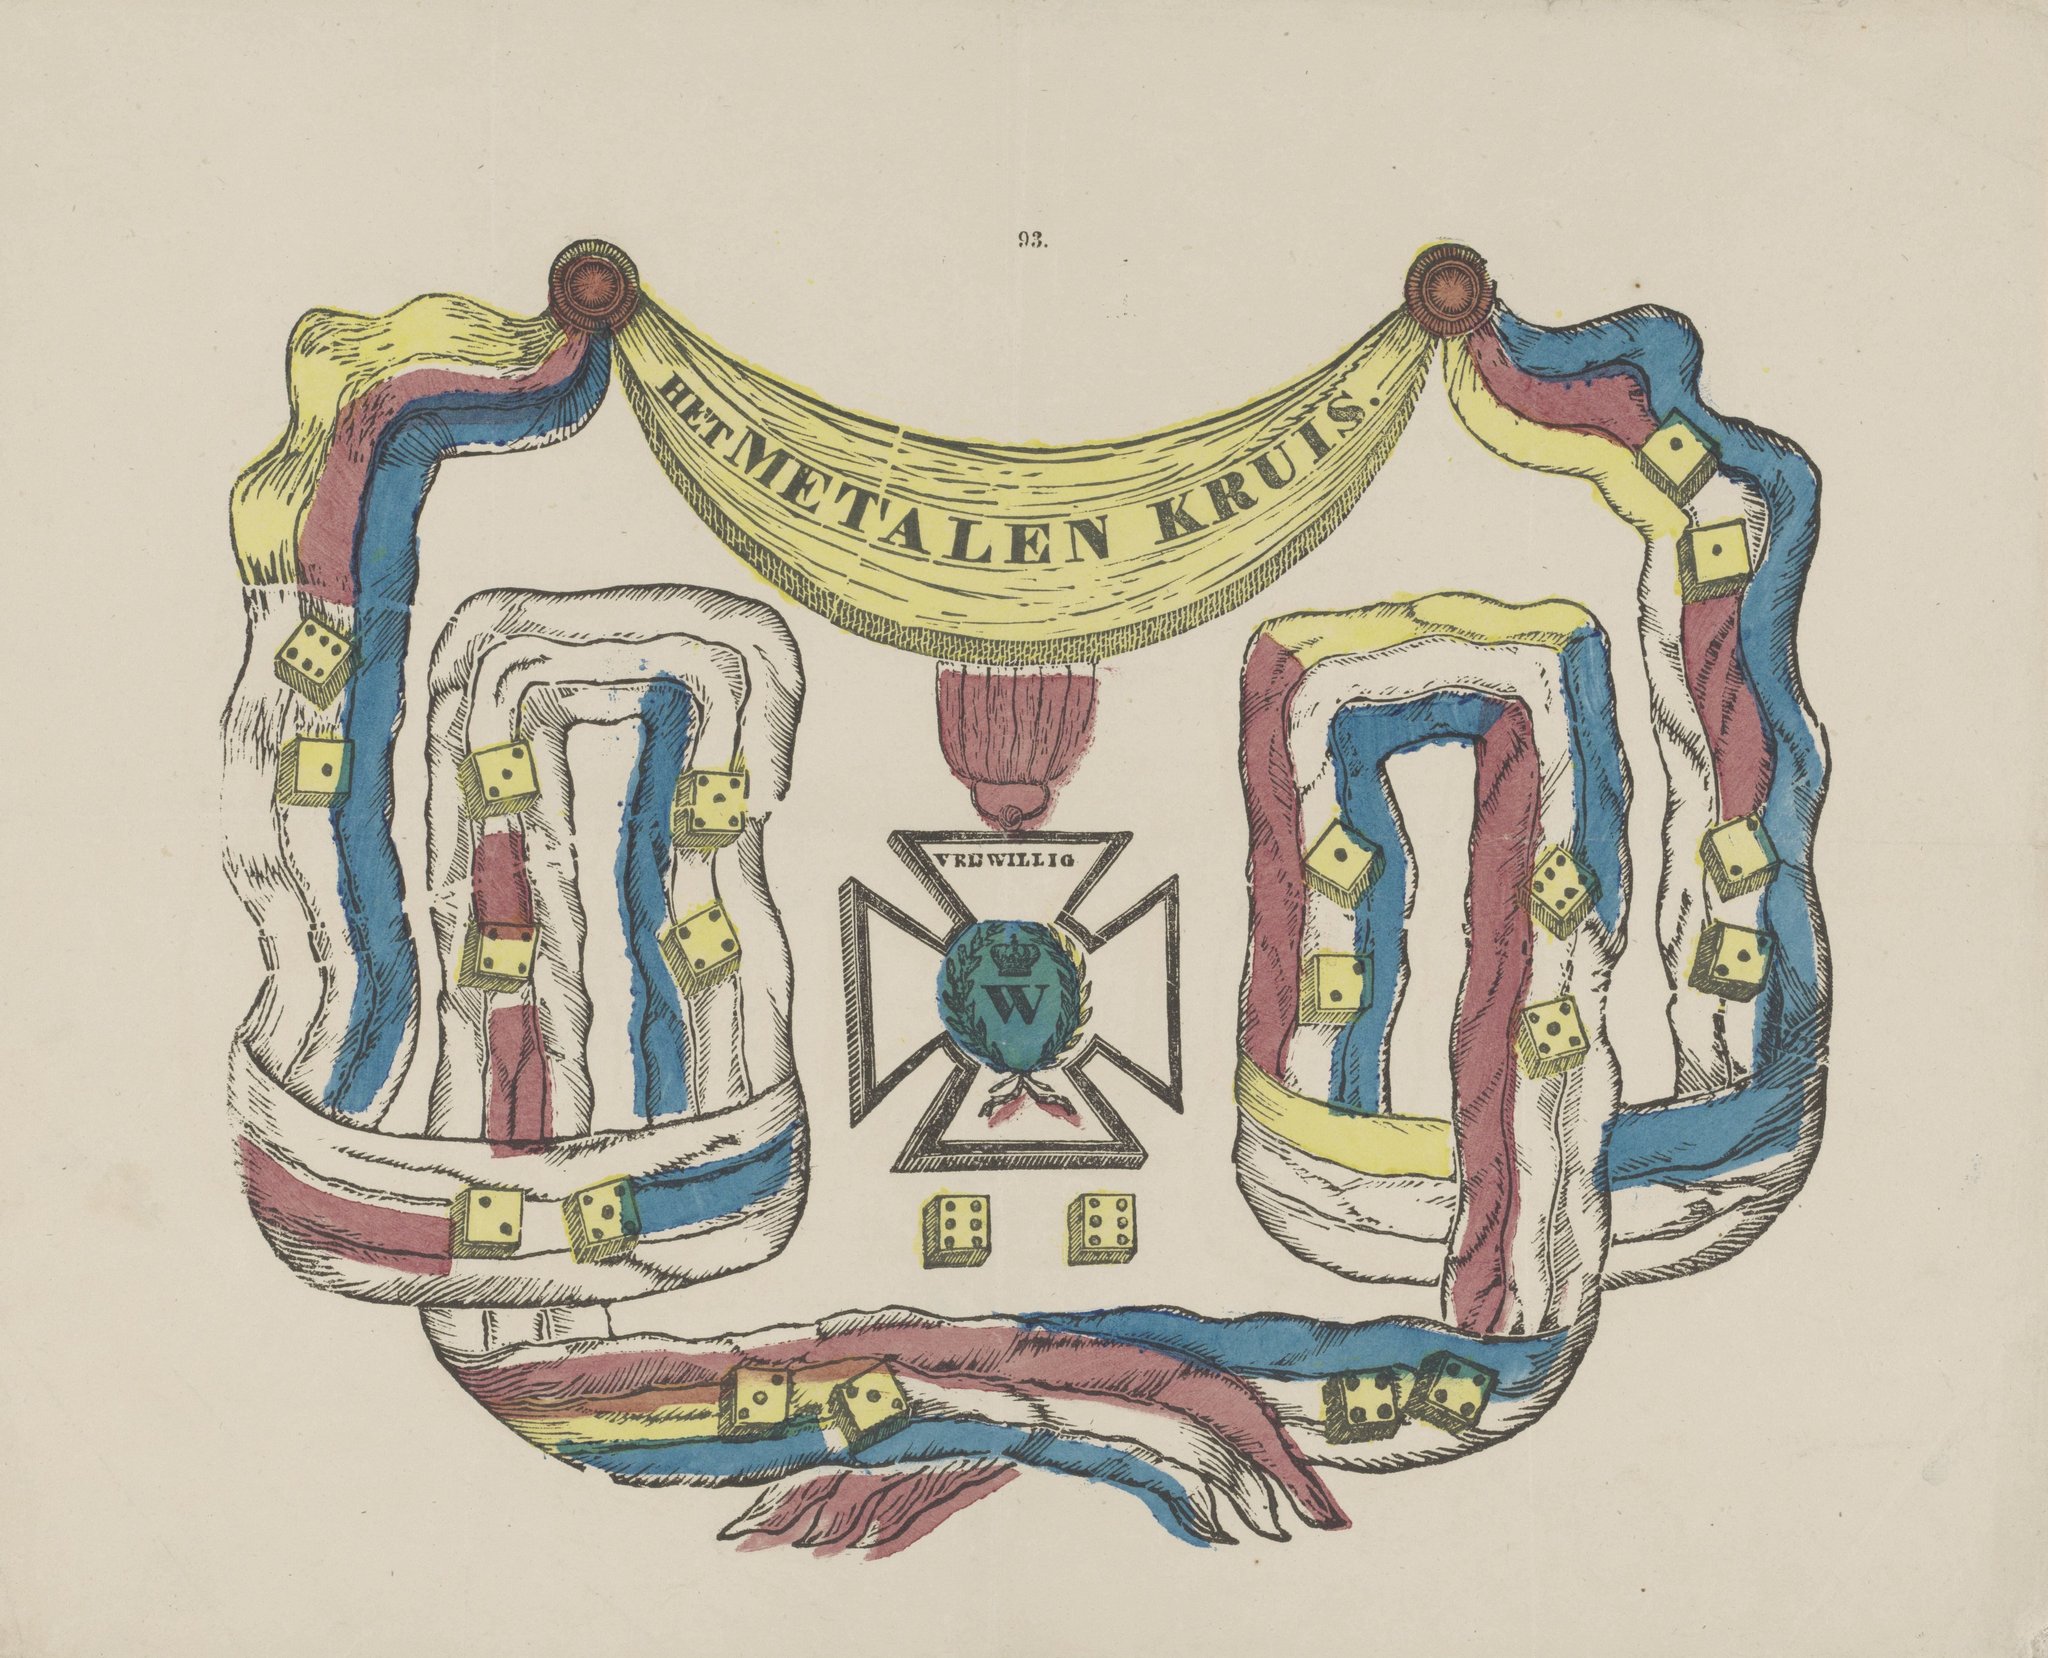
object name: popular print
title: Het metalen kruis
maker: Anonymous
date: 1848-1881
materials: paper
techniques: colour, letterpress printing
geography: netherlands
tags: board-games of chance, medals and other marks of military honour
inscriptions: collector's mark: Lugt 2760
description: Bordspel genaamd Het Metalen Kruis, 1832. Centraal het ereteken verleend door koning Willem I aan allen die gevochten hadden tijdens de Belgische revolutie in 1830-1831. Om het kruis ligt een kronkelig lint met dobbelstenen. Genummerd midden boven: 93.